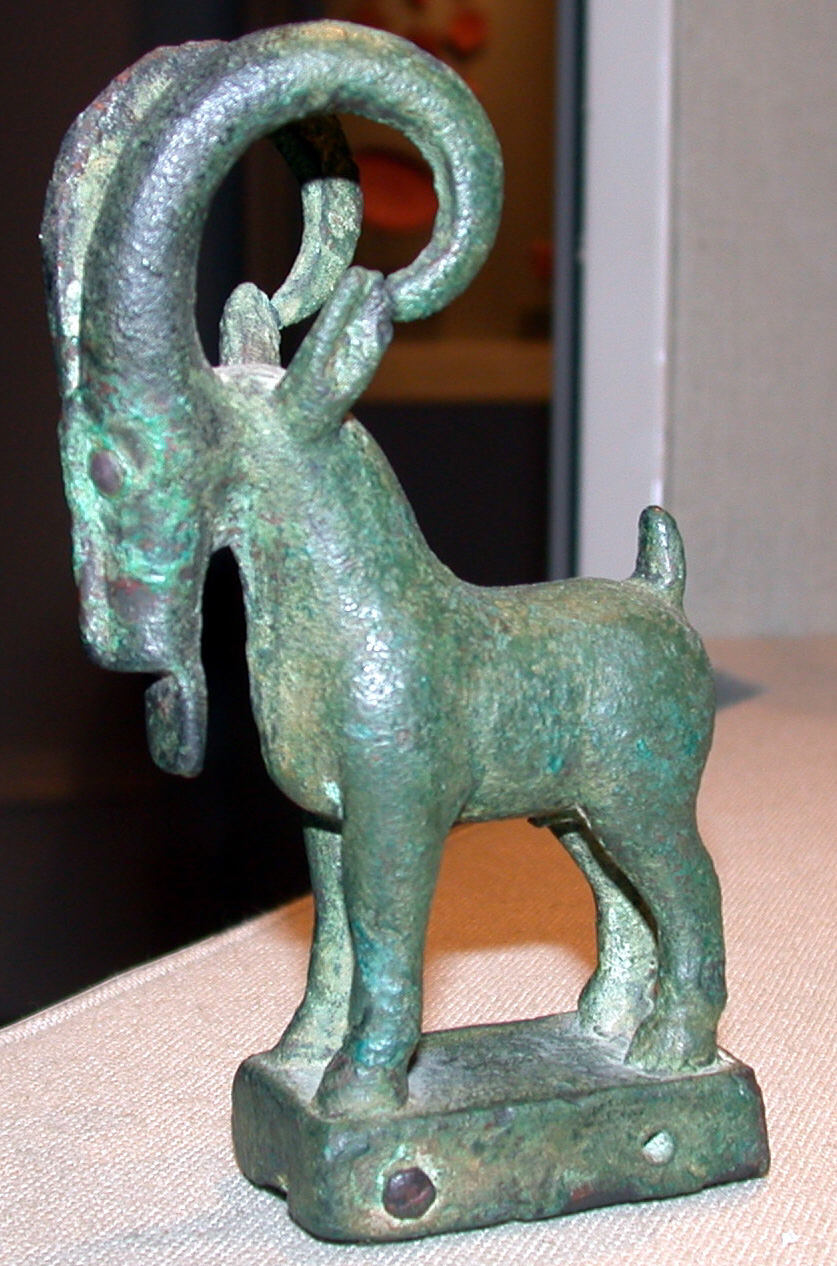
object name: sculpture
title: Figure of ibex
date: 500-401 BCE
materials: bronze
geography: southwestern arabia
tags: ibex